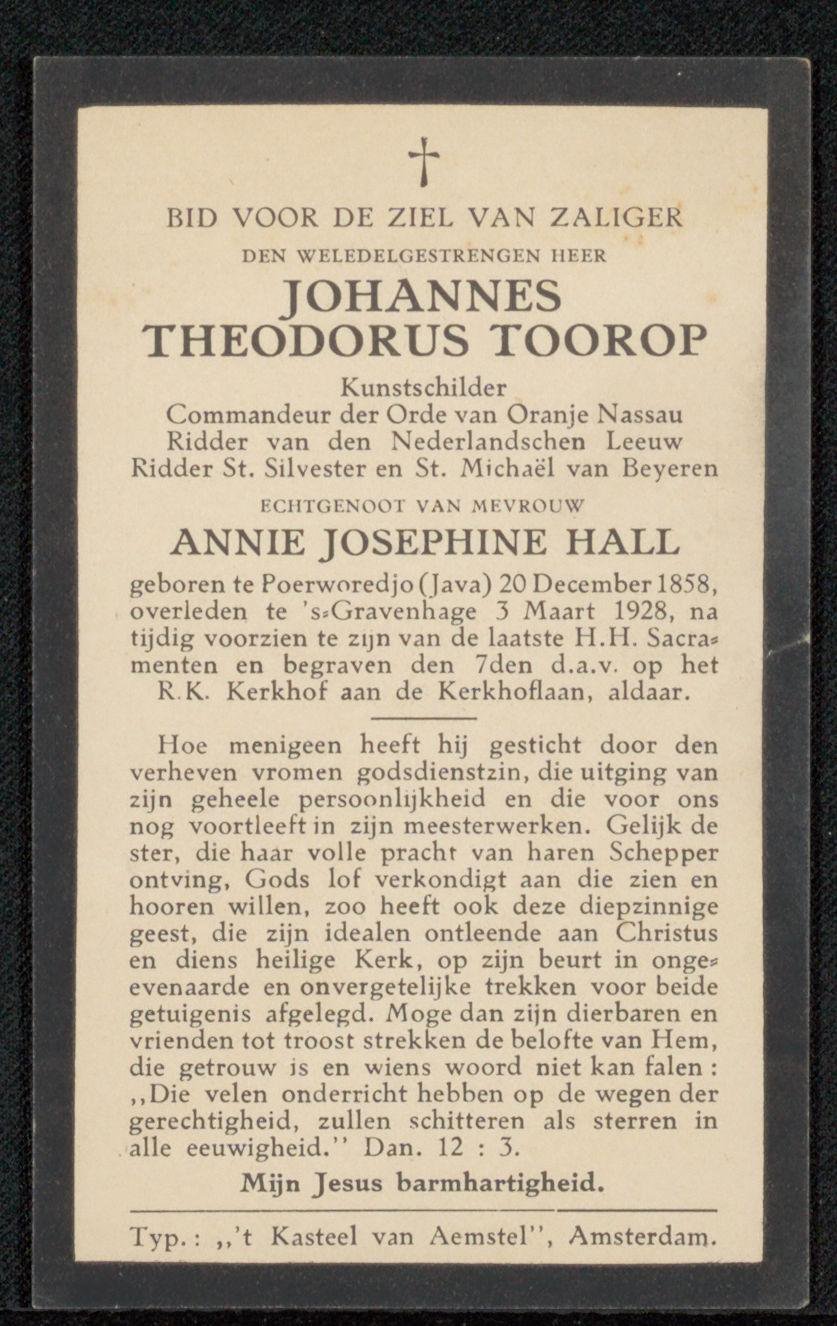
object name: doodsprent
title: Doodsprent uit archief Philip Zilcken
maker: Anonymous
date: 1928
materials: cardboard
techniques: printing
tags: the hague, painter, print maker, draughtsman, jan toorop, philip zilcken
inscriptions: collector's mark: ‘RPK’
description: Samen in een envelop met RP-D-1982-43-TOOROP-DOC.3 en RP-D-1982-43-TOOROP-DOC.4.